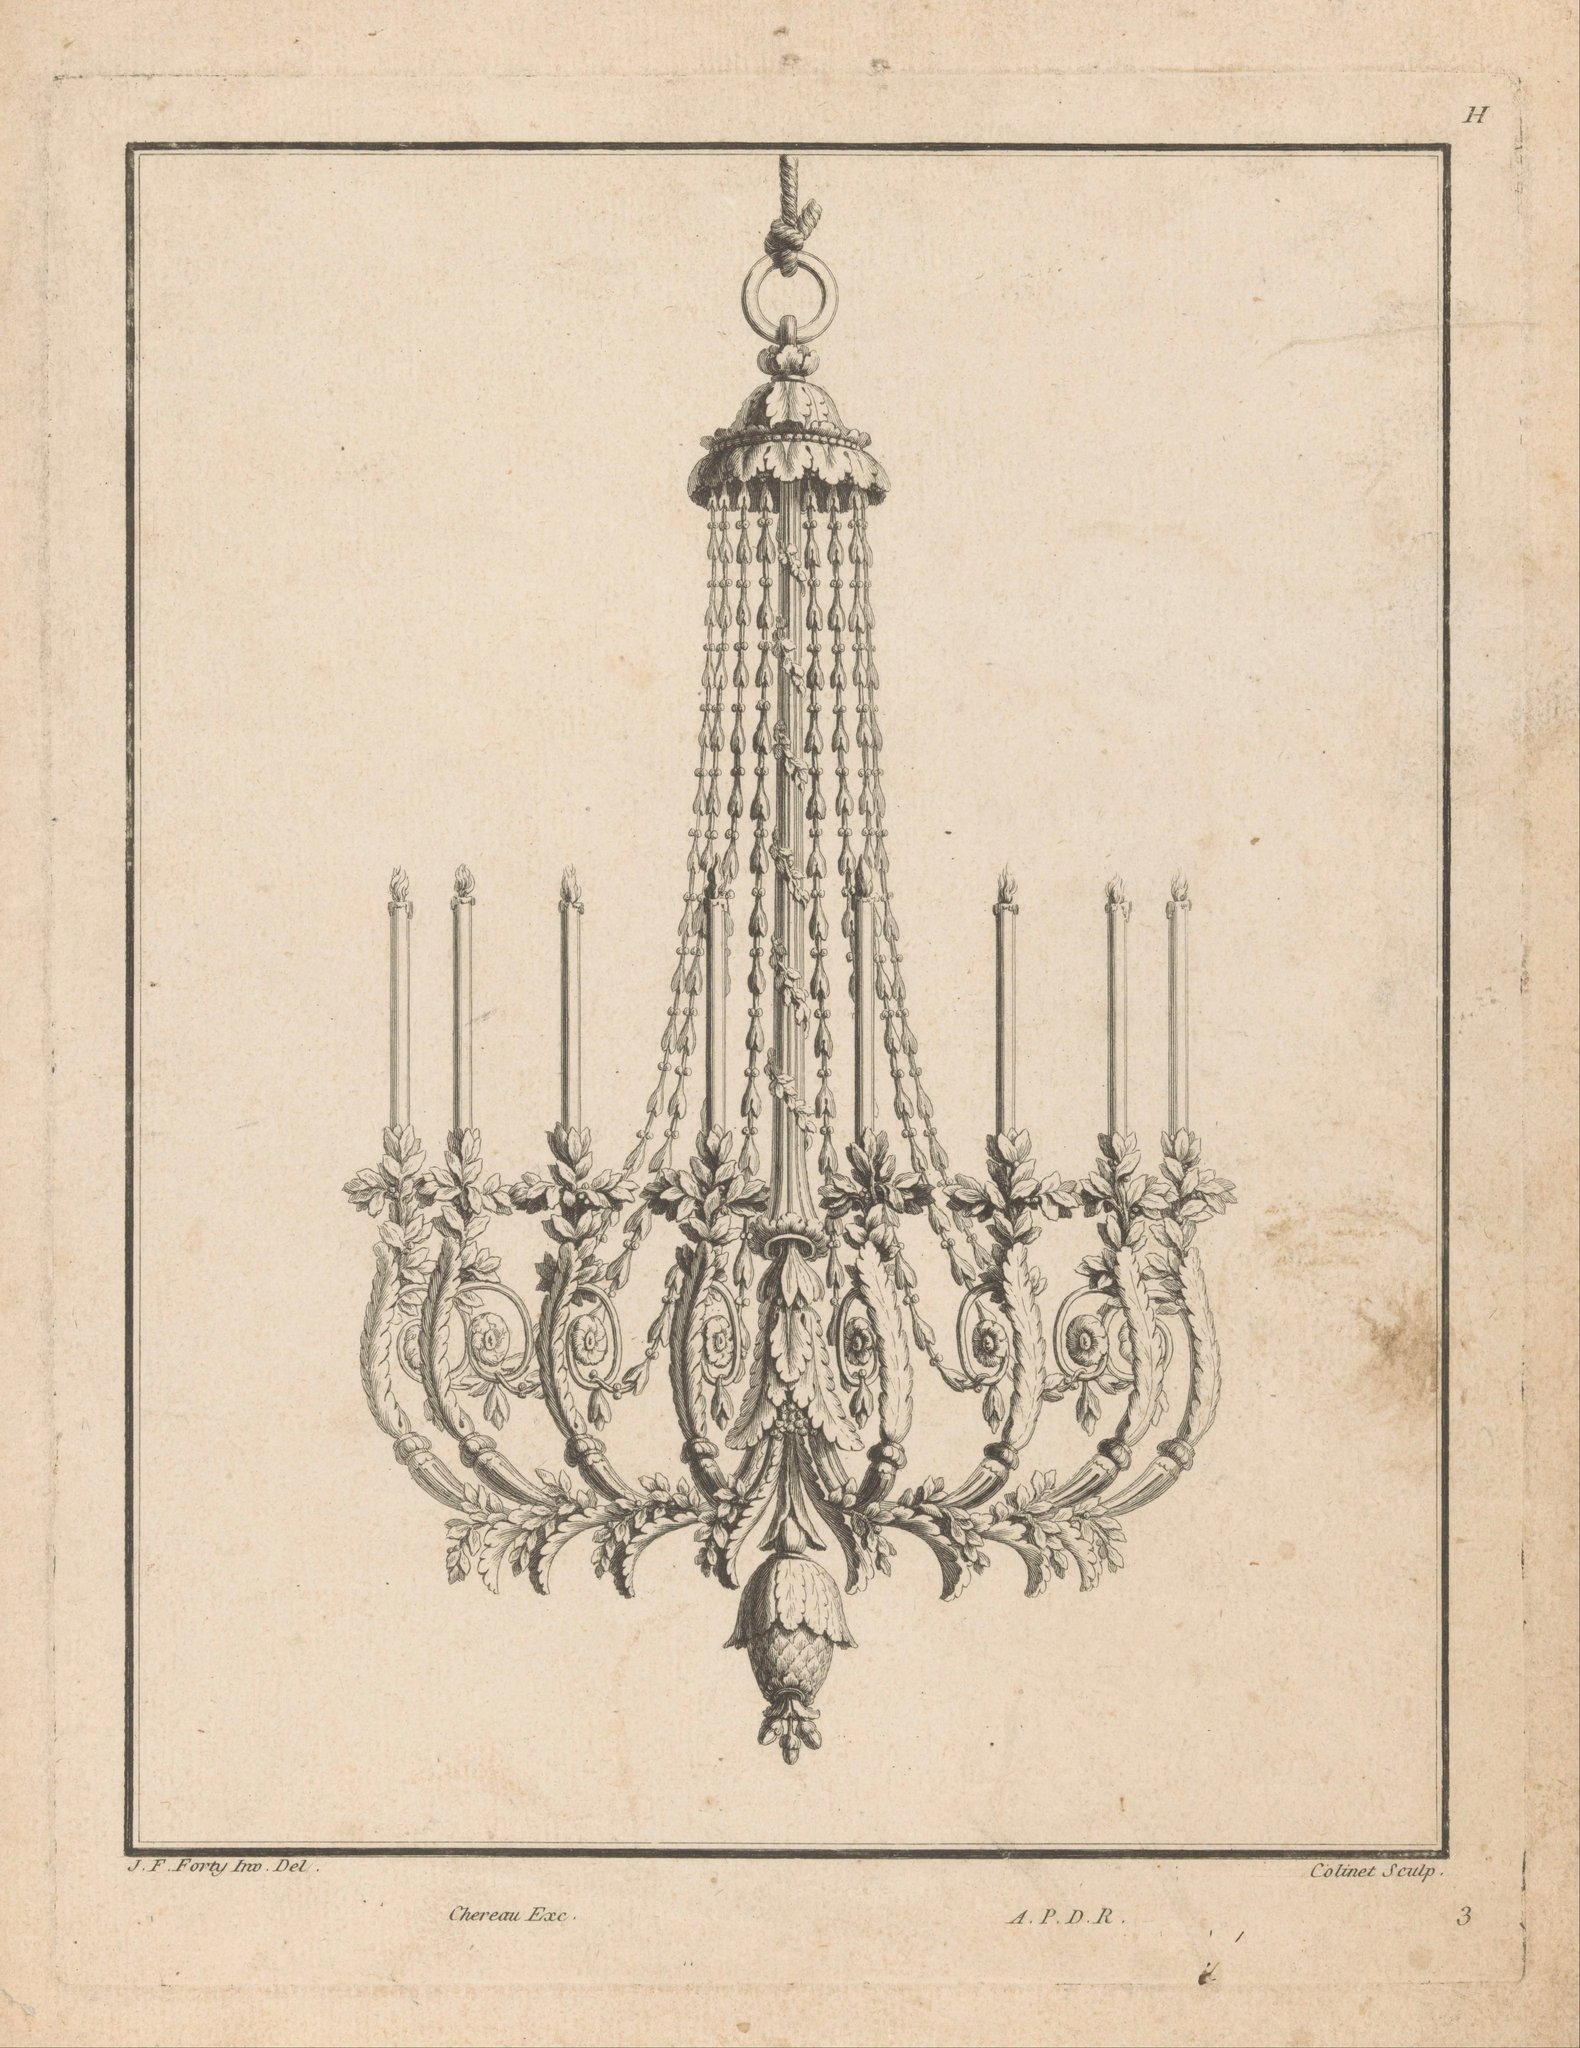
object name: print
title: 8e Cahier de l'Oeuvre H Cahier de six Lustres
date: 1775-1790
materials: paper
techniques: engraving, etching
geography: paris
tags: chandelier, candelabrum, flowers ~ ornament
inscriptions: collector's mark: Lugt 2228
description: Een geornamenteerde achtarmige kroonluchter met bloemen.